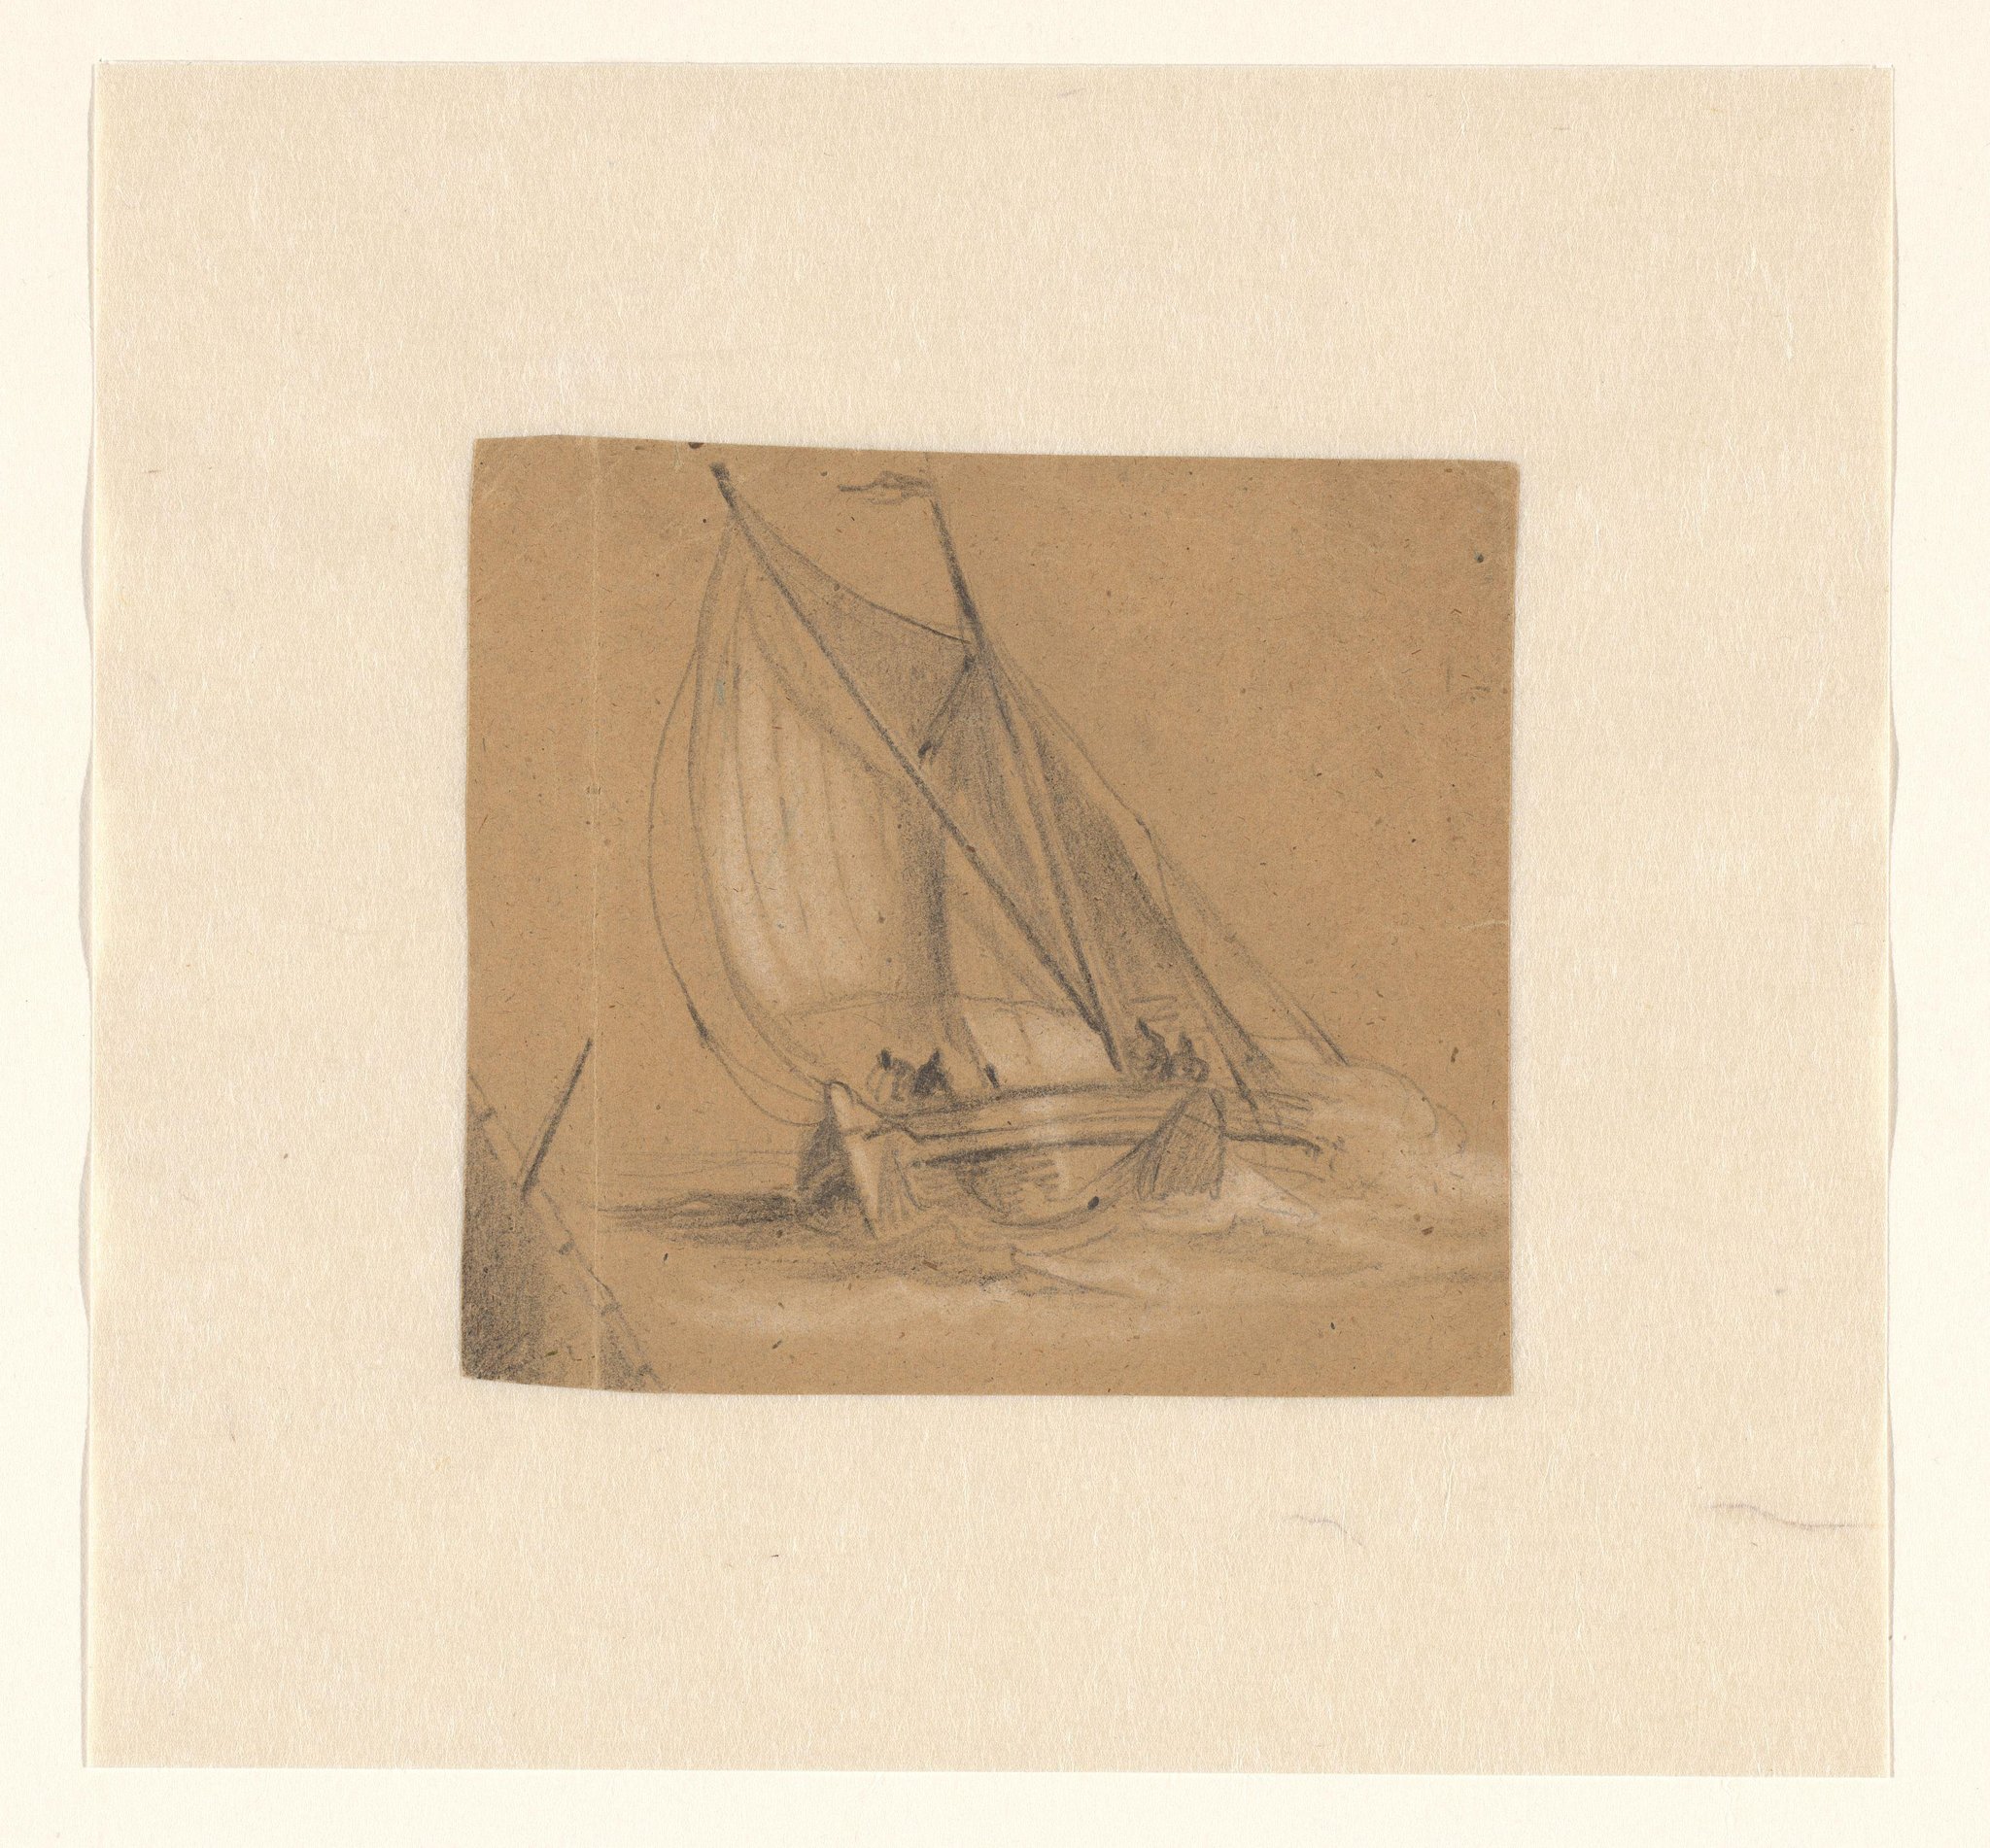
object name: drawing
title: Zeilend vissersschip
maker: johannes huygens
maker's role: draughtsman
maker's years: 1833-1911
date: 1843-1911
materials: chalk, paper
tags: sailing-ship, sailing-boat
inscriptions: name: ‘Joh Huygens’